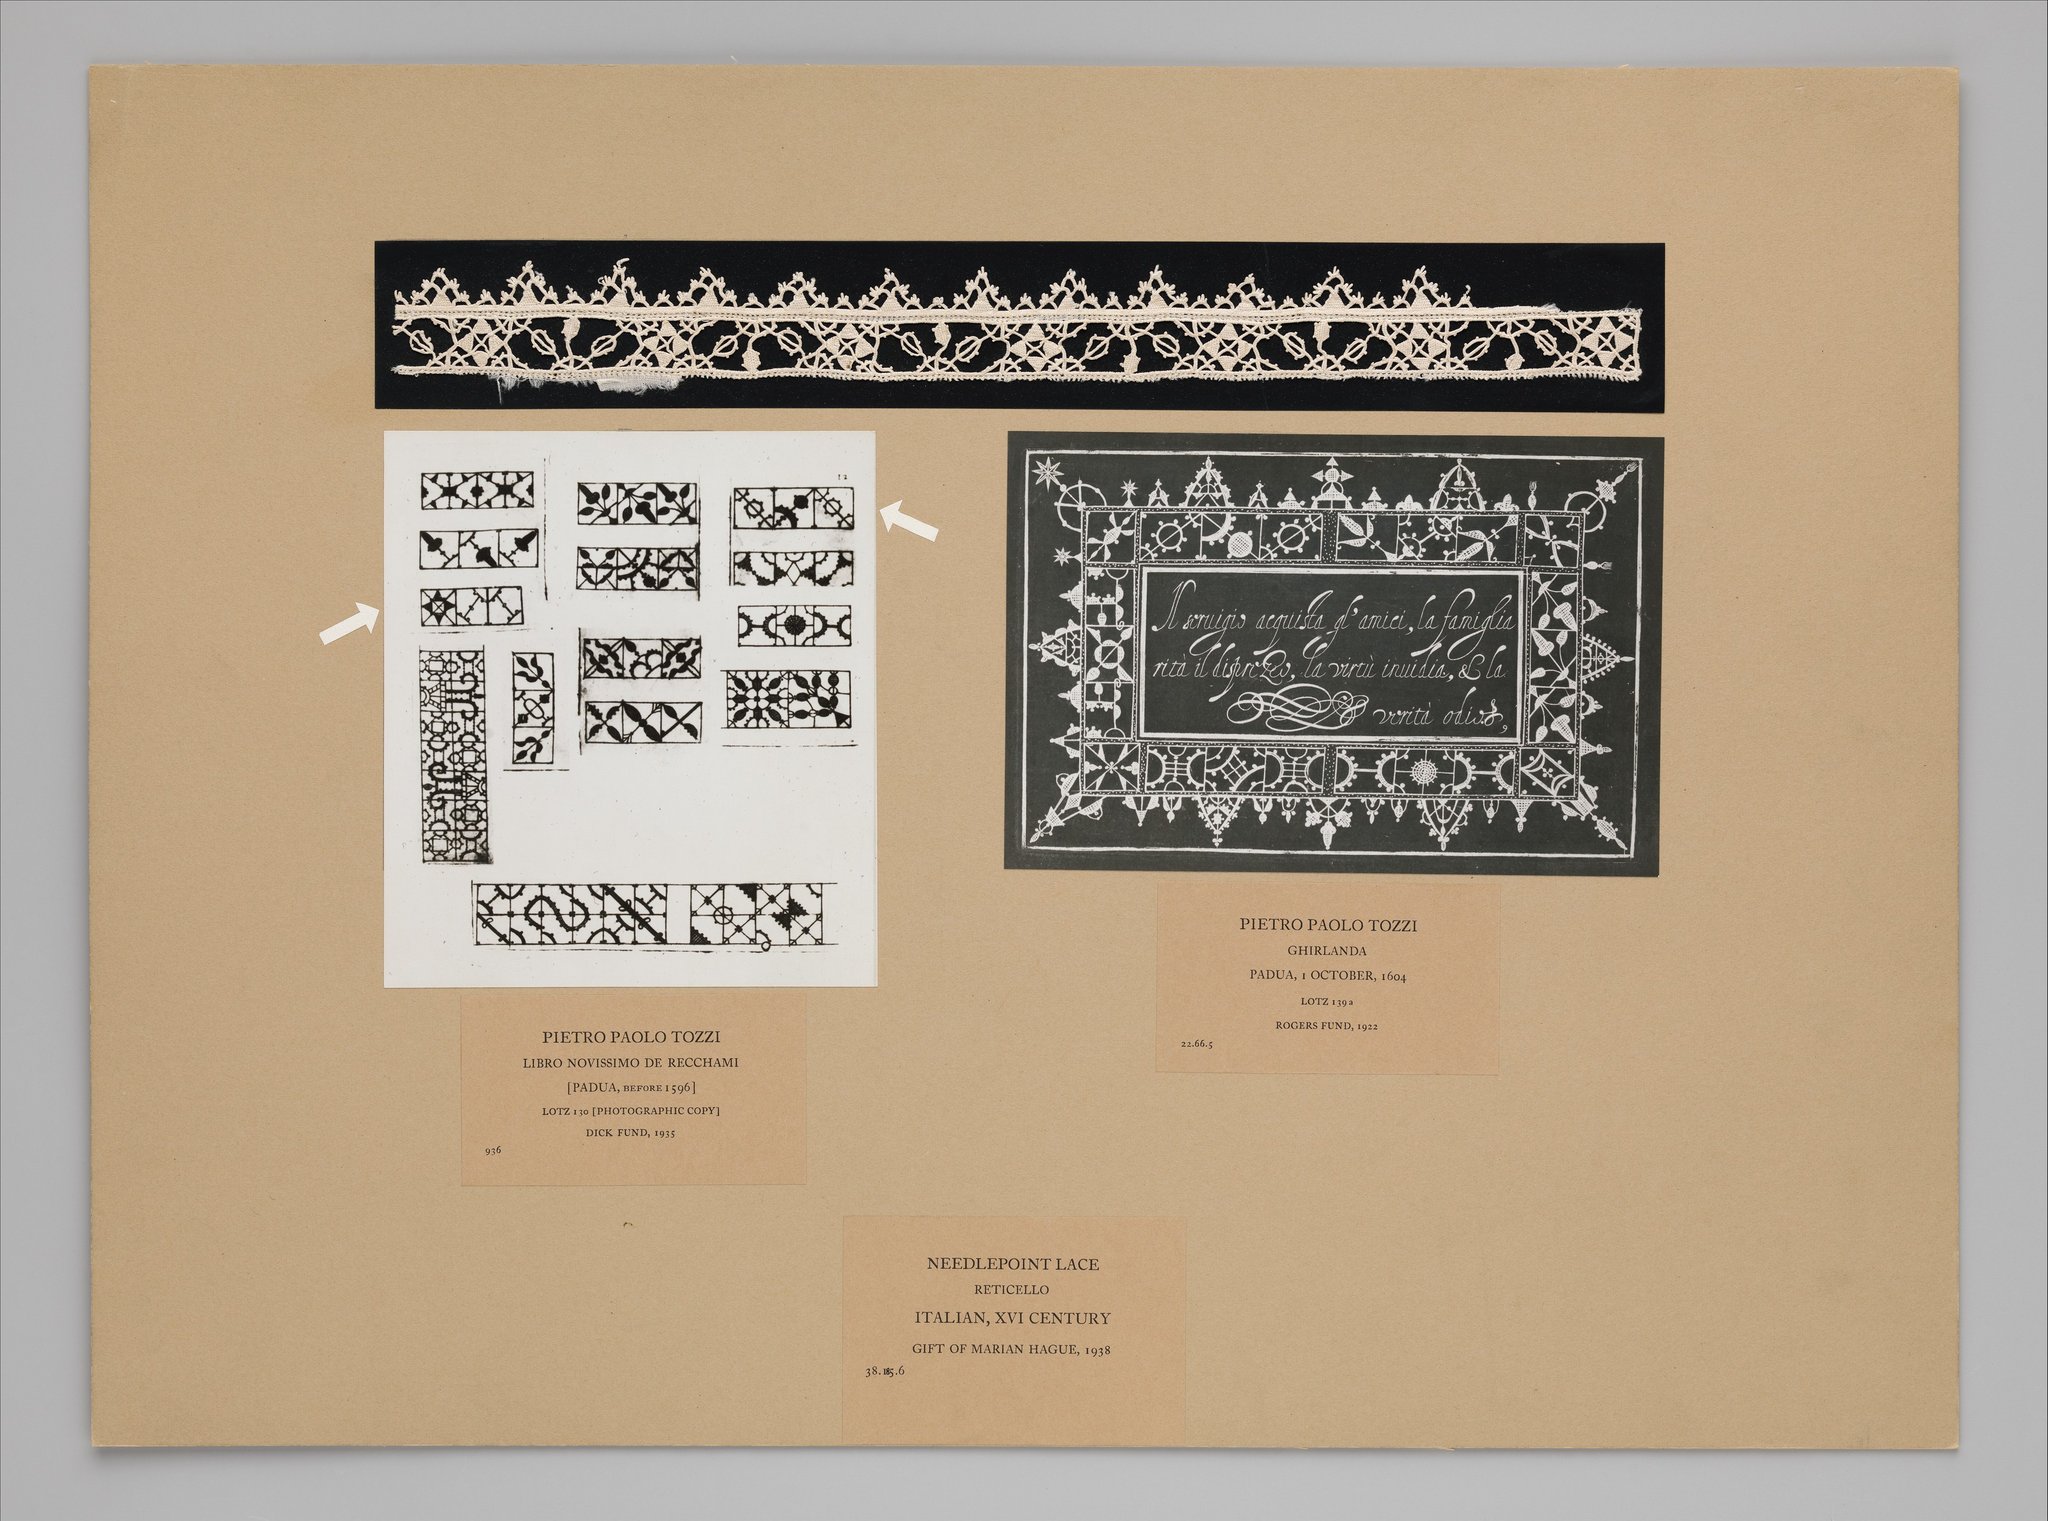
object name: edging and insertion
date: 1501-1600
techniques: lace